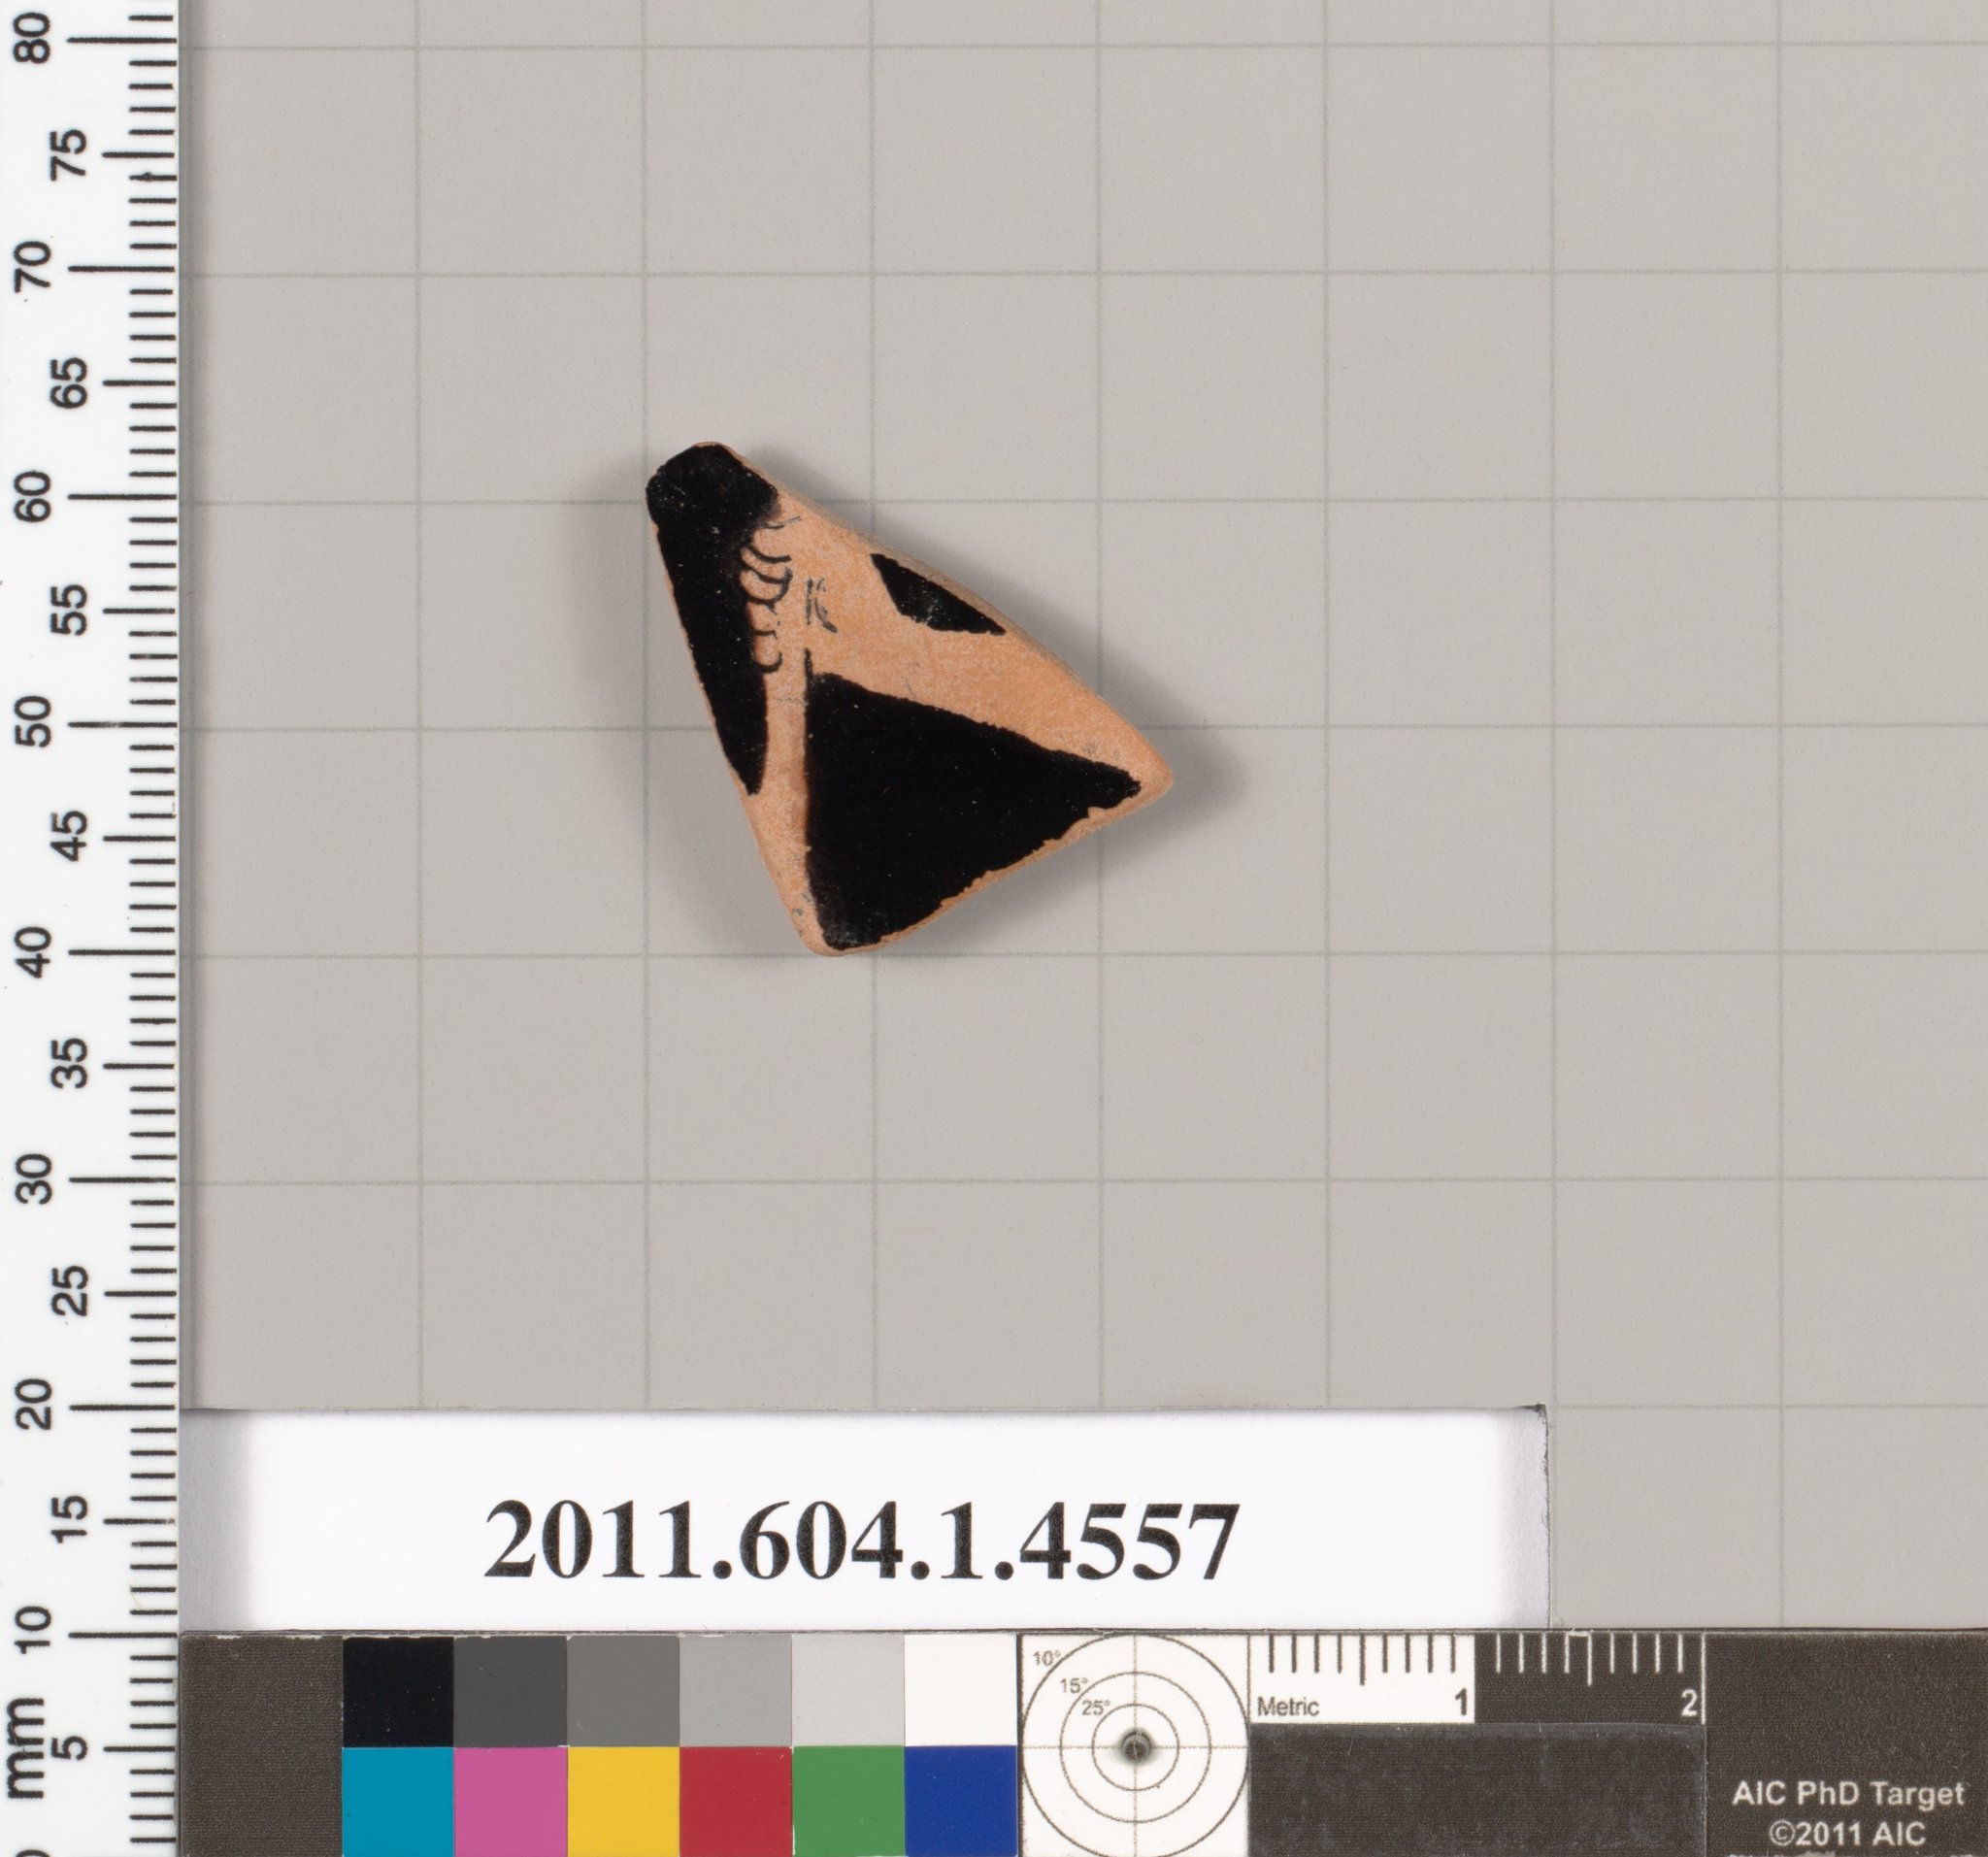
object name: kylix fragment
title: Terracotta fragment of a kylix (drinking cup)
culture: greek, attic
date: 500-470 BCE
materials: terracotta